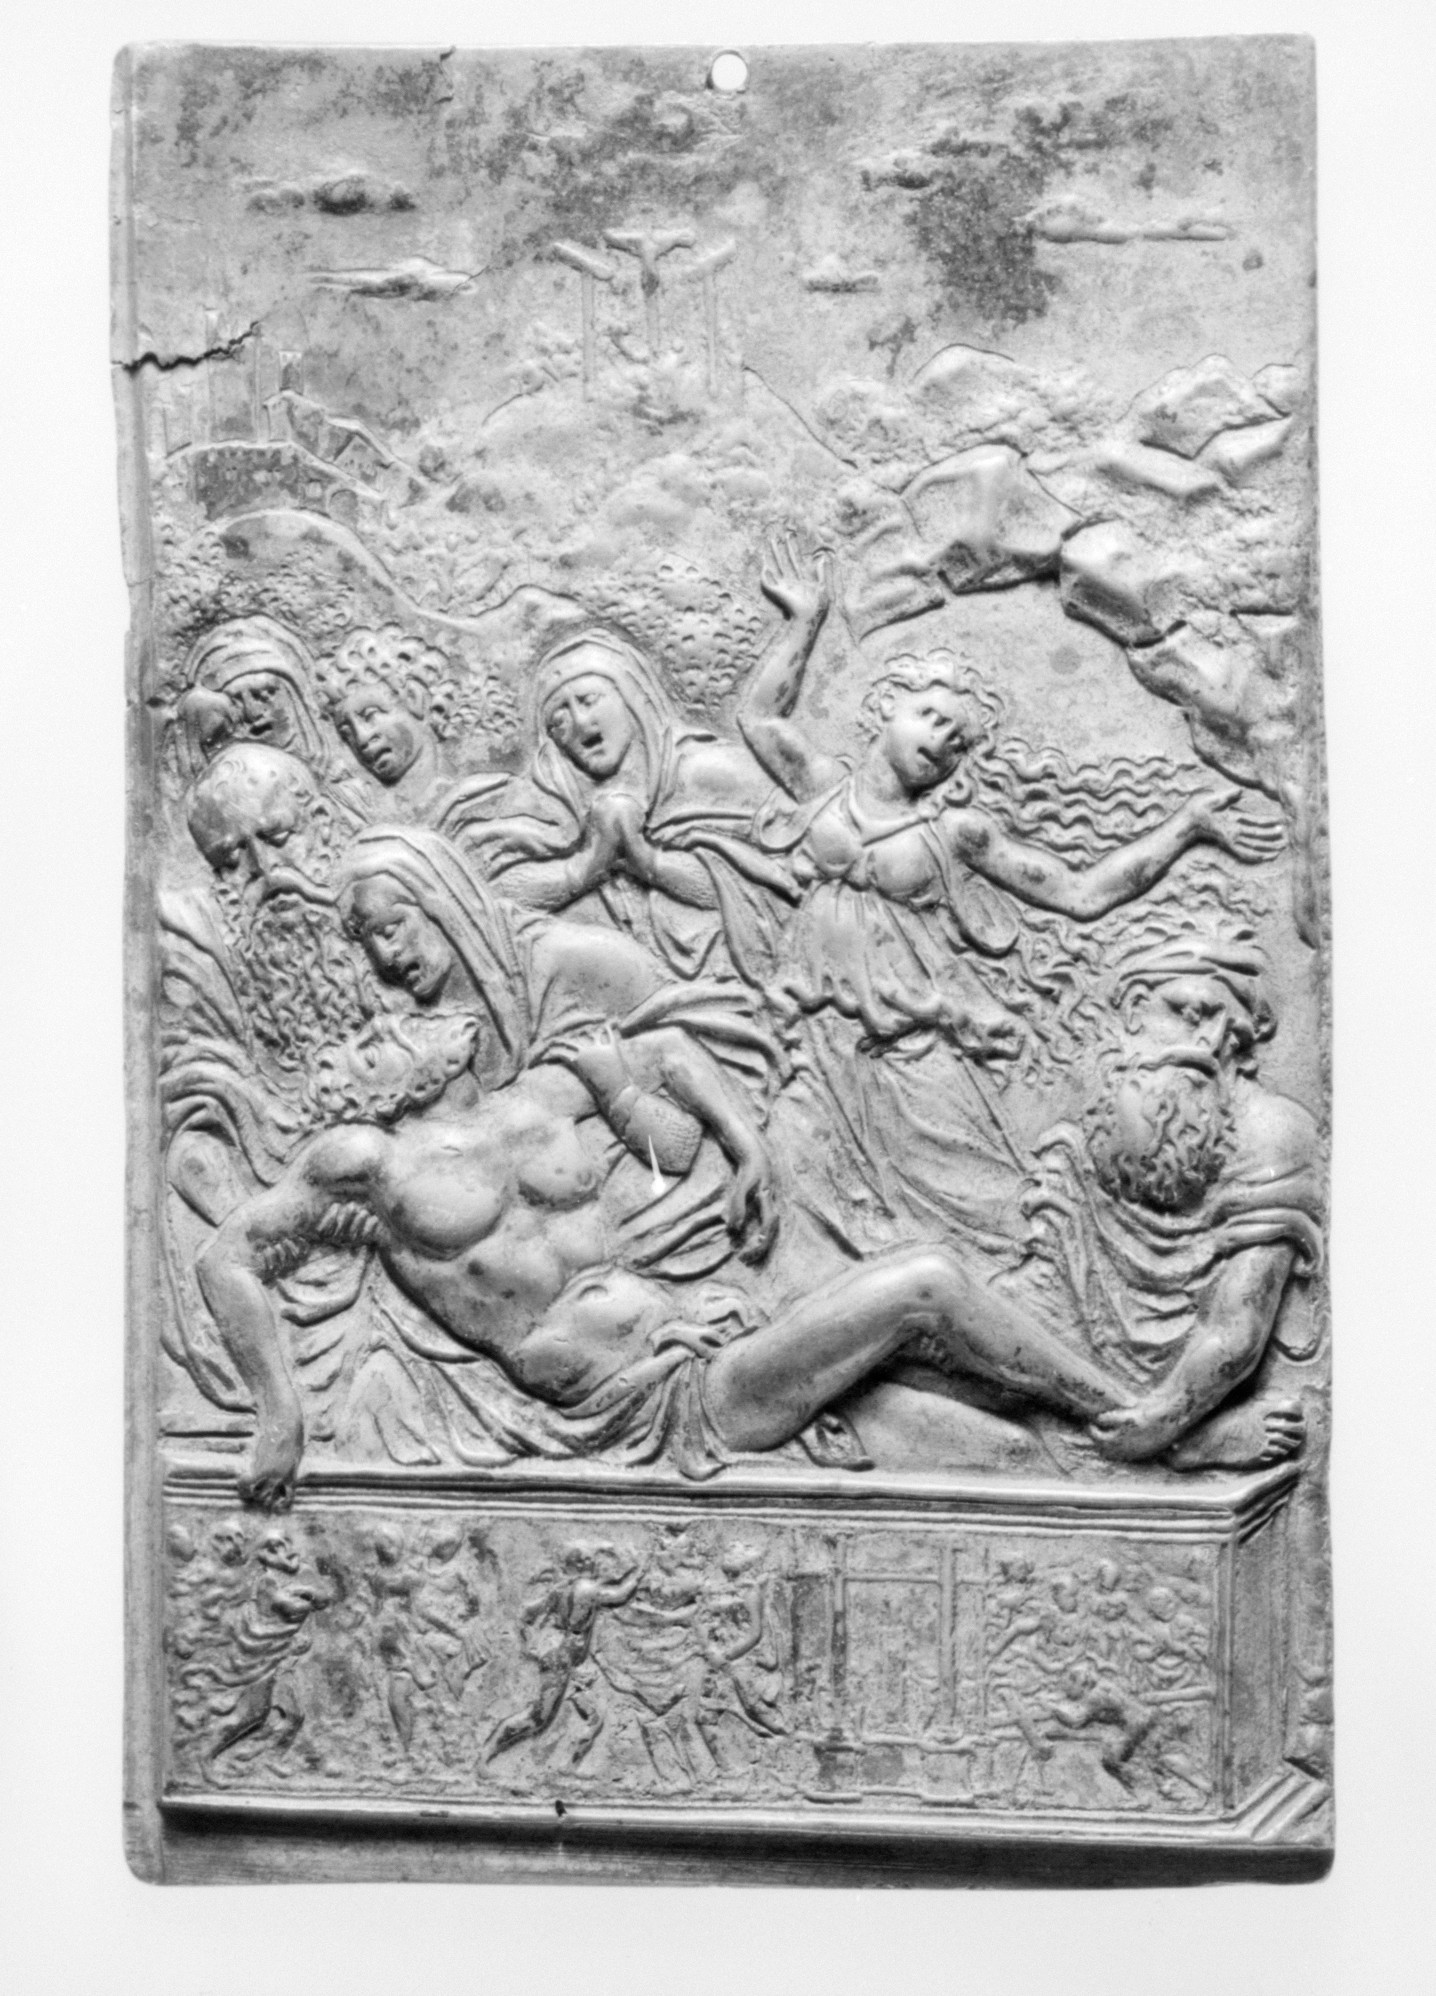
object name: plaquette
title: The Entombment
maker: moderno (galeazzo mondella)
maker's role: artist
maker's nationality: italian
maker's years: 1467-1528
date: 1501-1600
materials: bronze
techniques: silvered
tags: sadness,christ,mary magdalene,virgin mary,entombment